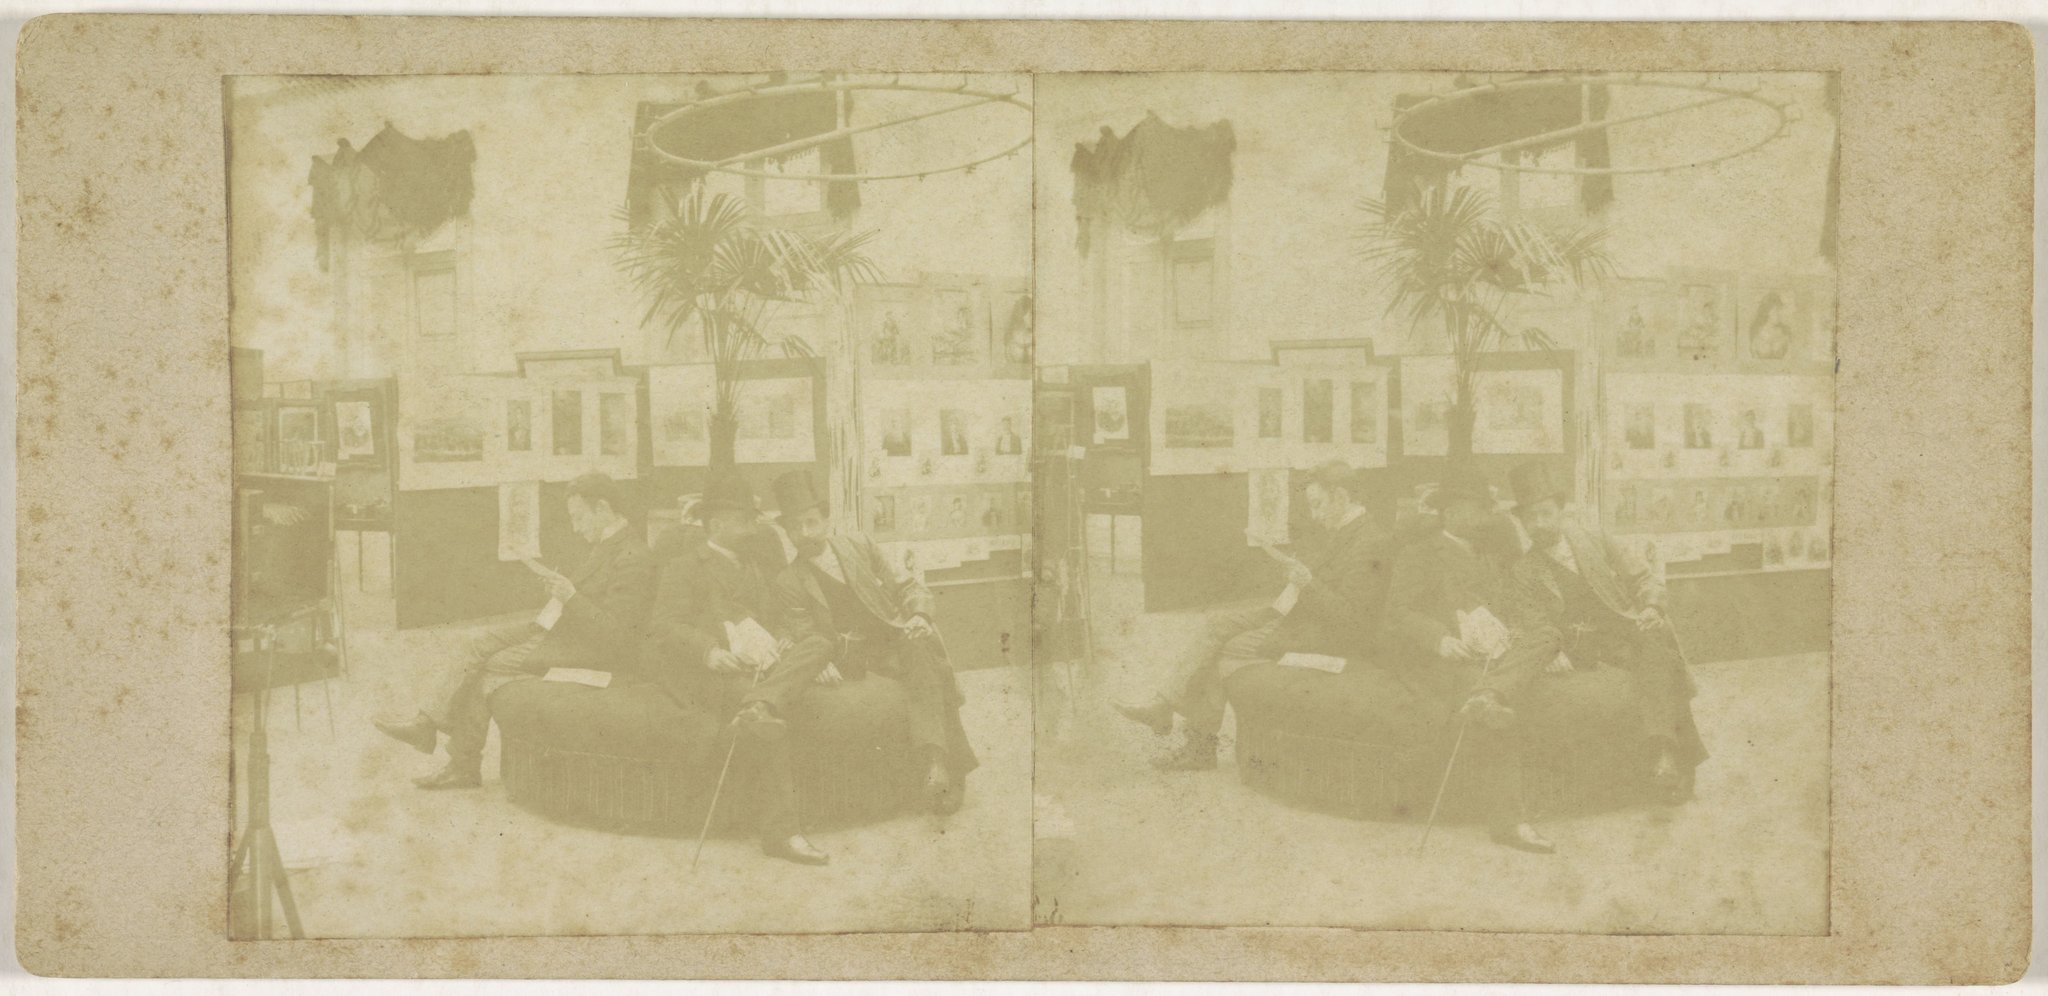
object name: stereograph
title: Bezoekers op een ronde bank op een van de fotografietentoonstellingen, vermoedelijk in de Militiezaal in Amsterdam 1891 of 1895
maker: Anonymous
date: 1891-1895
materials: cardboard, paper, photographic support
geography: amsterdam